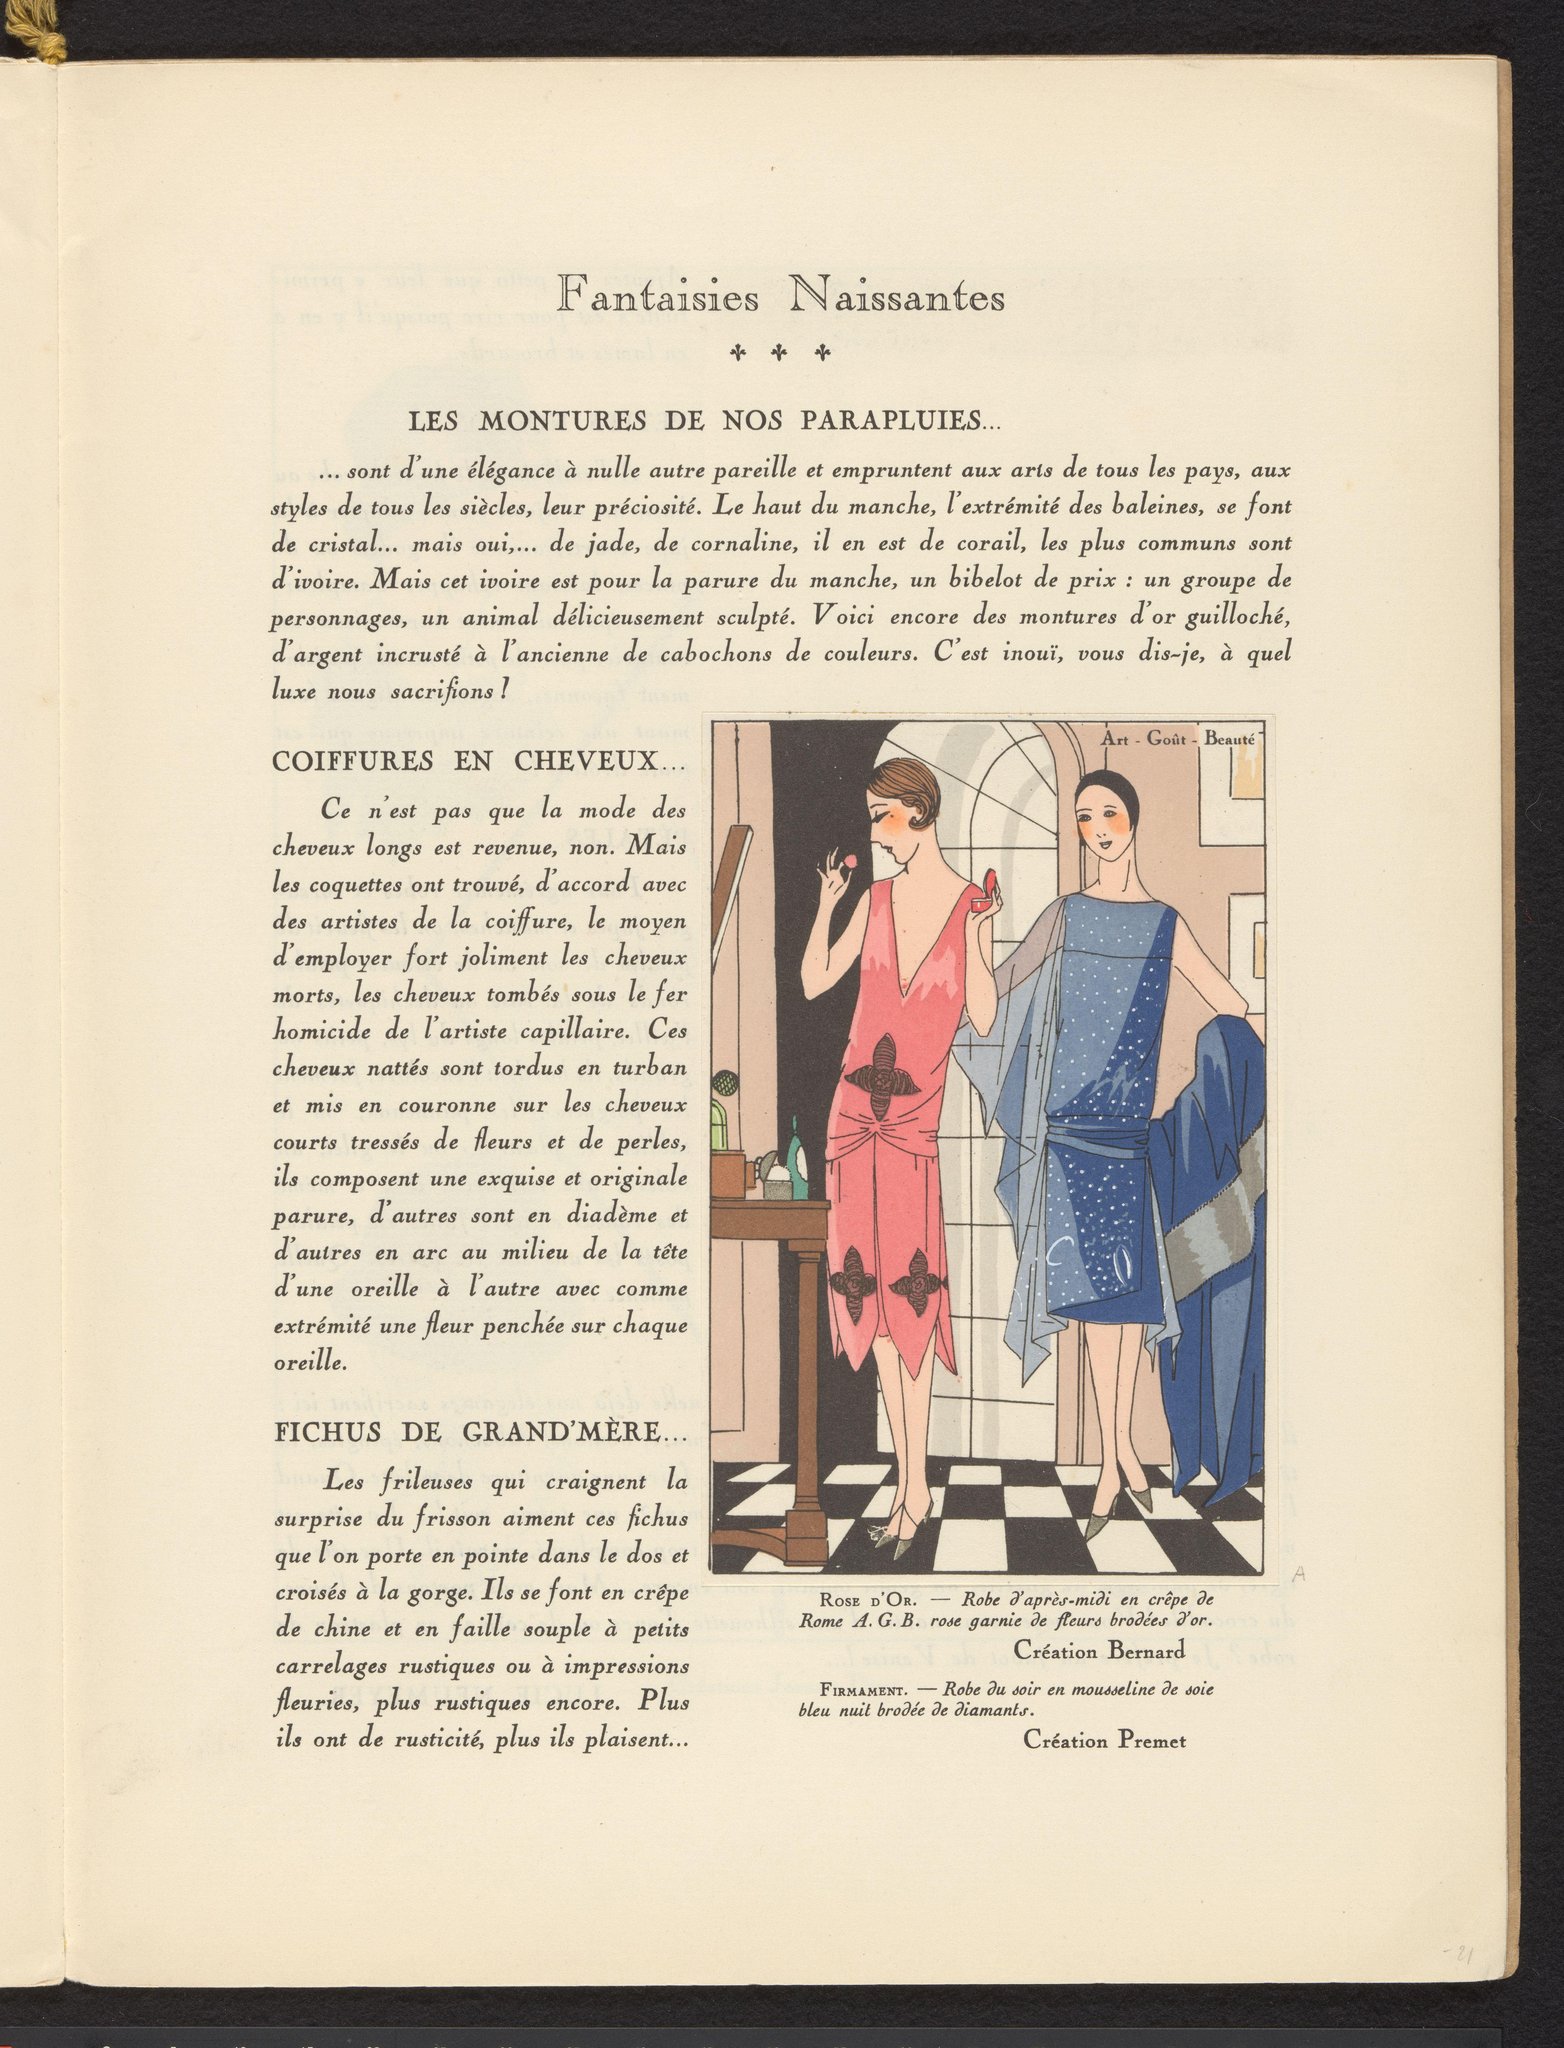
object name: magazine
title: Art - Goût - Beauté, Feuillets de l' élégance féminine, Février 1926, No. 66, 6e Année, p. 21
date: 1926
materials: paper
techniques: hand coloring, lithograph, pochoir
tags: dress, gown: evening dress (+ women's clothes), powder ~ making toilet, dress, gown: day dress (+ women's clothes), fashion plates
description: Tekst 'Fantaisies Naissantes' met een afbeelding. Links: middagjapon van Bernard. Rechts: avondjurk van donkerblauwe zijdemousseline, van Premet. Pagina uit het modetijdschrift Art-Goût-Beauté (1920-1933).